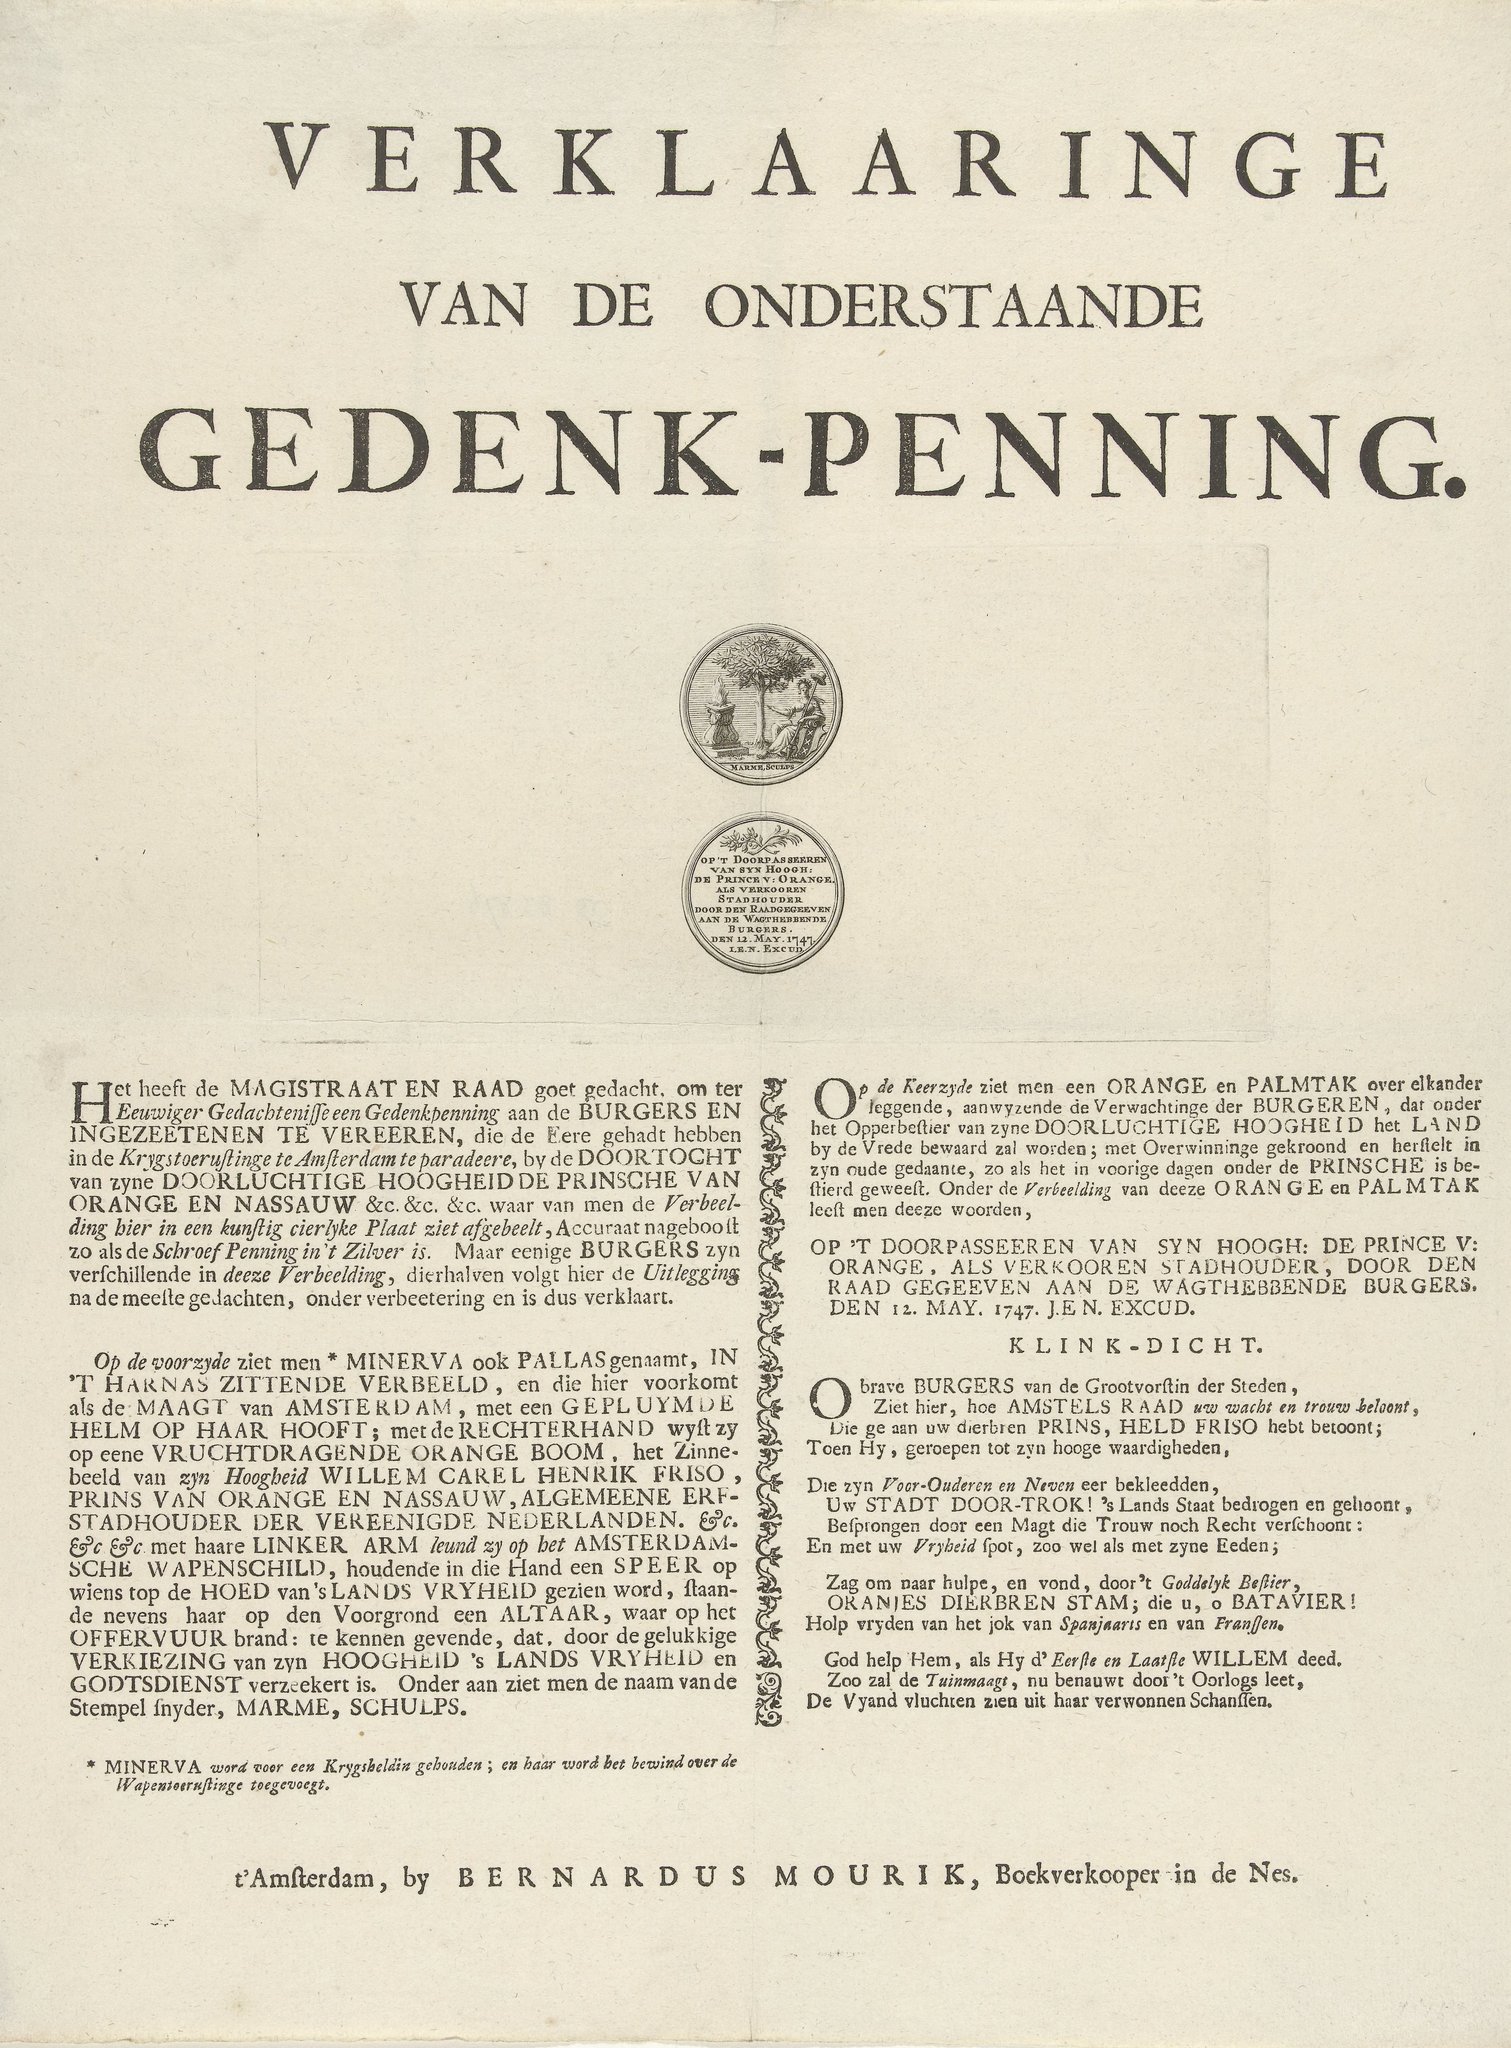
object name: penningverklaring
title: Penning op de verheffing van de prins van Oranje tot stadhouder, uitgedeeld aan de wachthebbende burgers van de stad Amsterdam ter ere van de doortocht van de prins door de stad, 1747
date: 1747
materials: paper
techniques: etching, letterpress printing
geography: amsterdam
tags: the hague, willem iv (prins van oranje-nassau), medal (considered as a piece of sculpture, regardless of its specific function), amsterdam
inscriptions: collector's mark: Lugt 2228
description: Blad met een voorstelling van beide zijden van de penning op de verheffing van de prins van Oranje tot stadhouder, uitgedeeld door Magistraat en Raad van de stad Amsterdam aan de wachthebbende burgers van de stad Amsterdam ter ere van de doortocht van de prins door de stad, 12 mei 1747. De penning wordt in de verklaring aangeduid als een schroefpenning. Op het blad onder de plaat een verklaring van de voorstelling op de penning en een klinkdicht.